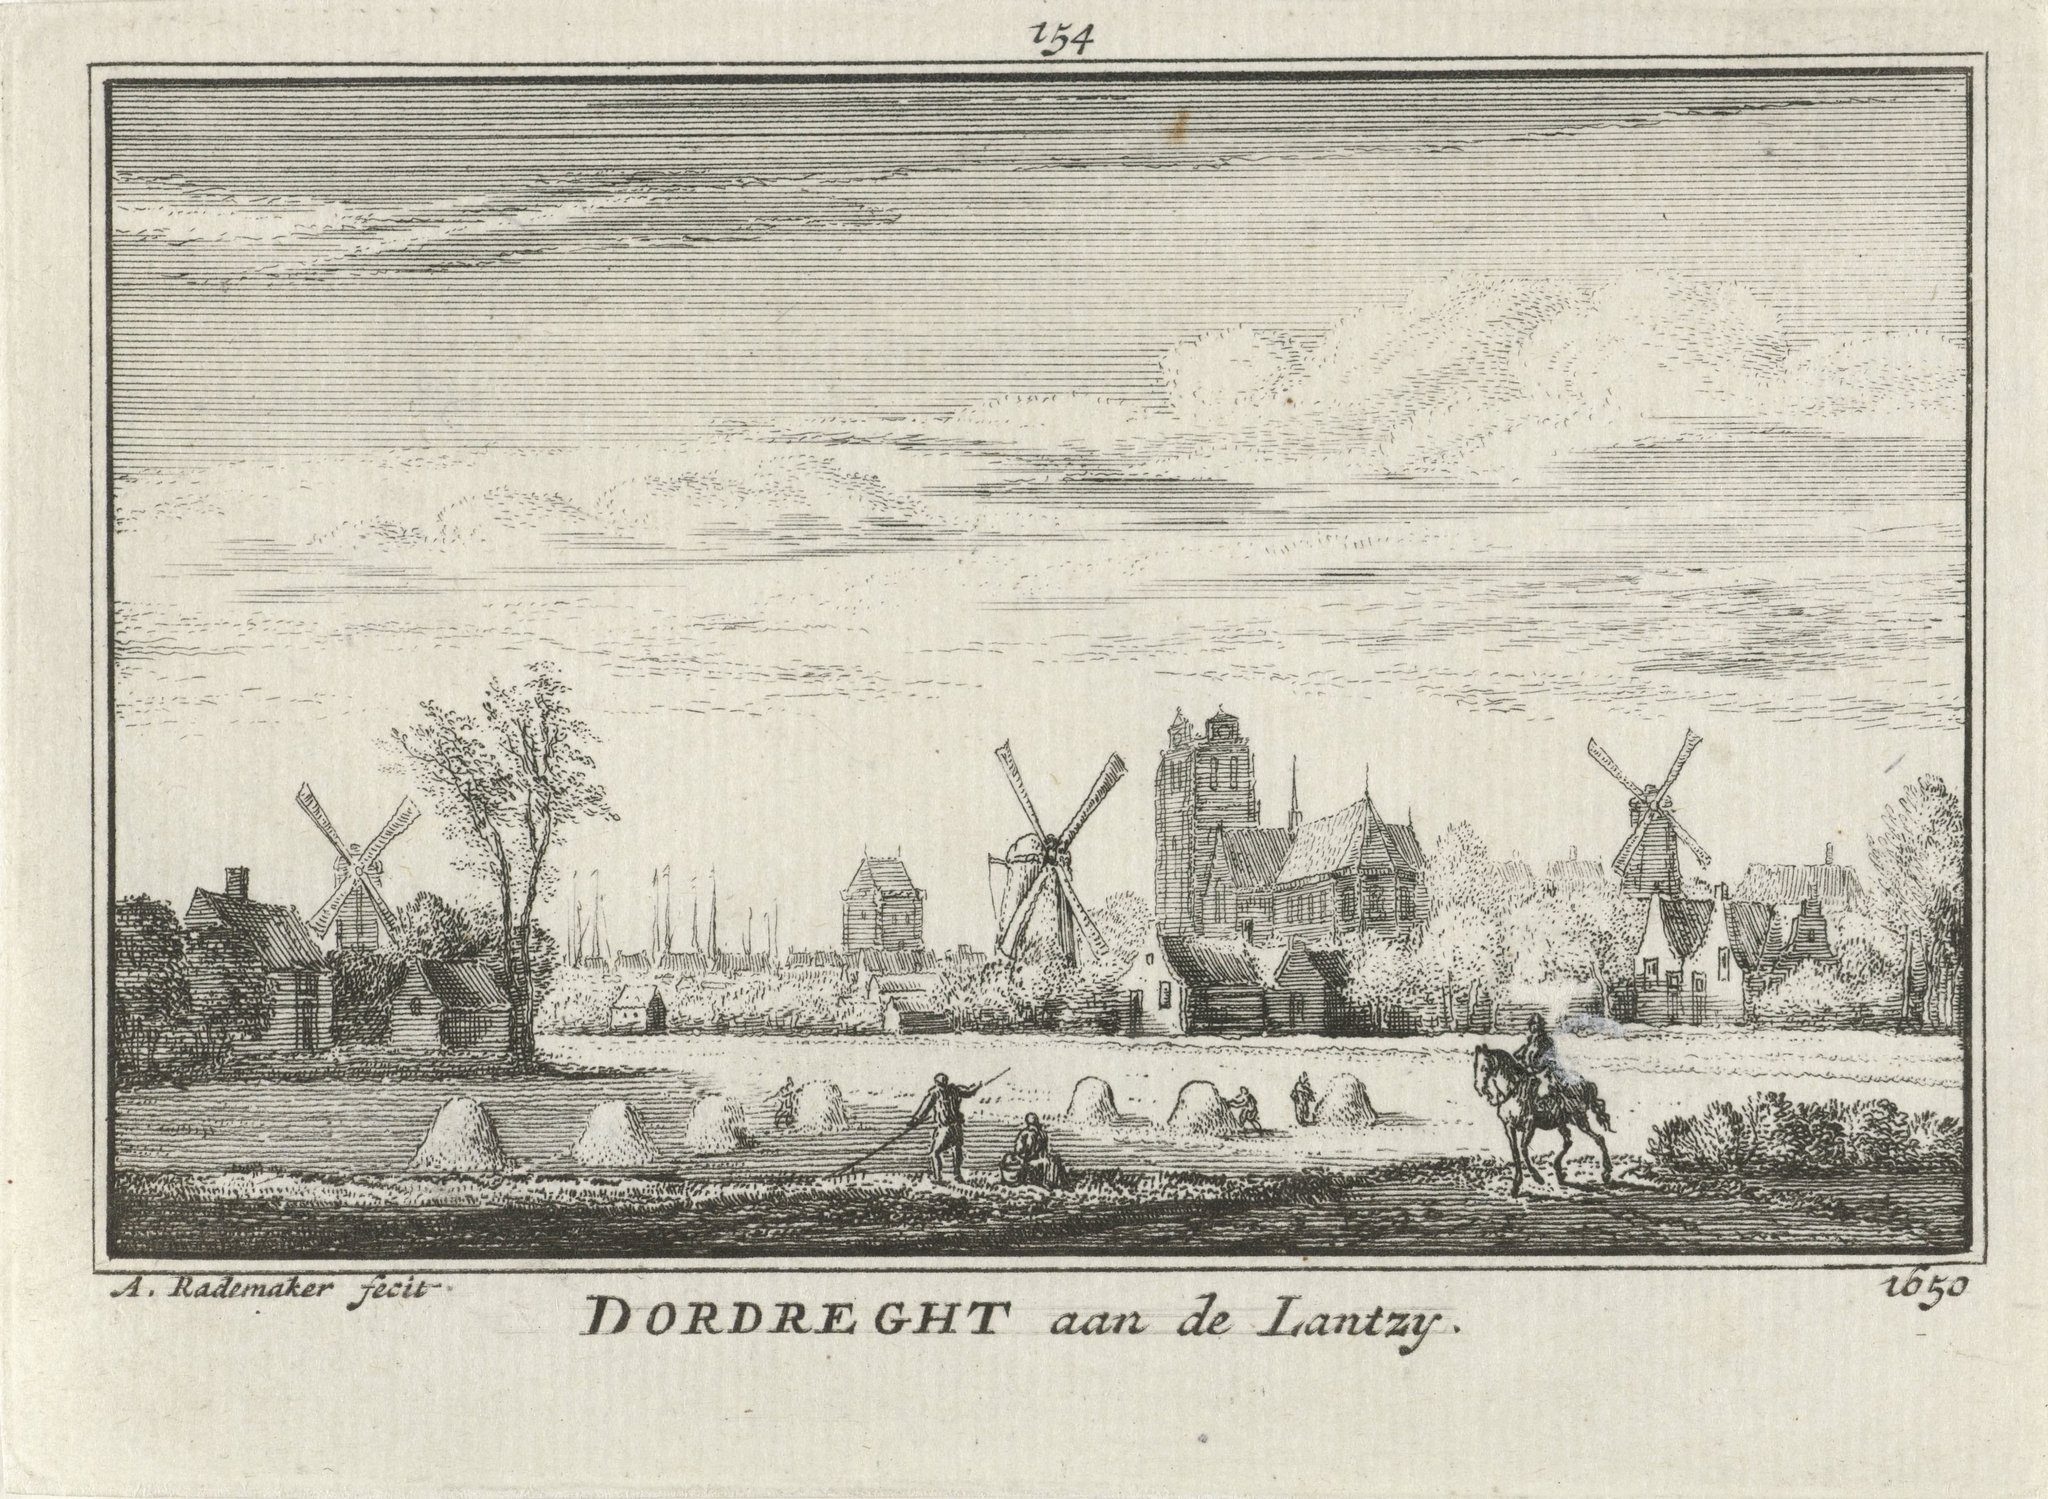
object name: print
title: Gezicht op Dordrecht, 1650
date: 1727-1733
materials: paper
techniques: etching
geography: amsterdam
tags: riding a horse, ass, or mule; rider, horseman, farmers, church (exterior), windmill, prospect of city, town panorama, silhouette of city, dordrecht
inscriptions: collector's mark: Lugt 2228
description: Illustratie uit: Abraham Rademaker, Matthaeus Brouërius van Niedek, Isaac Le Long, Kabinet van Nederlandsche en Kleefsche outheden en (...) voorname stads- en landgebouwen, Willem Barents en Antoni Schoonenburg: Amsterdam, 1727-1733, ill. nr. 153.